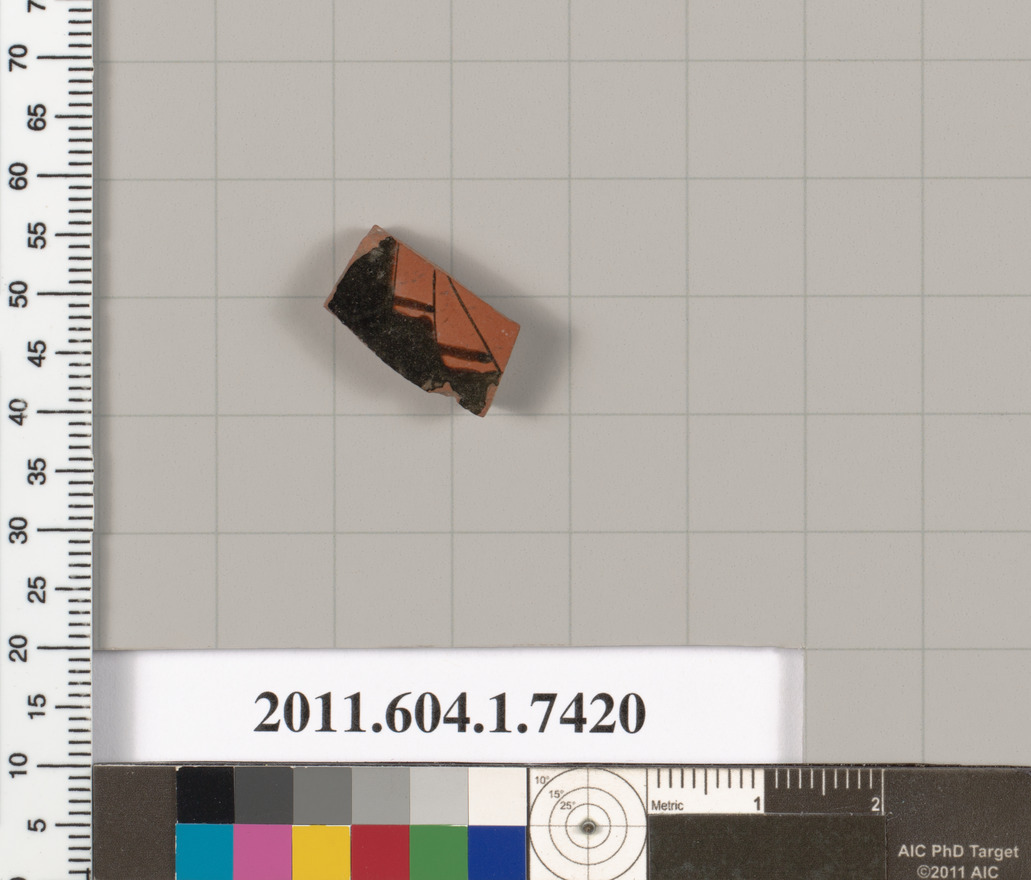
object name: kylix fragment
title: Terracotta fragment of a kylix (drinking cup)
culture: greek, attic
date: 490-470 BCE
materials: terracotta